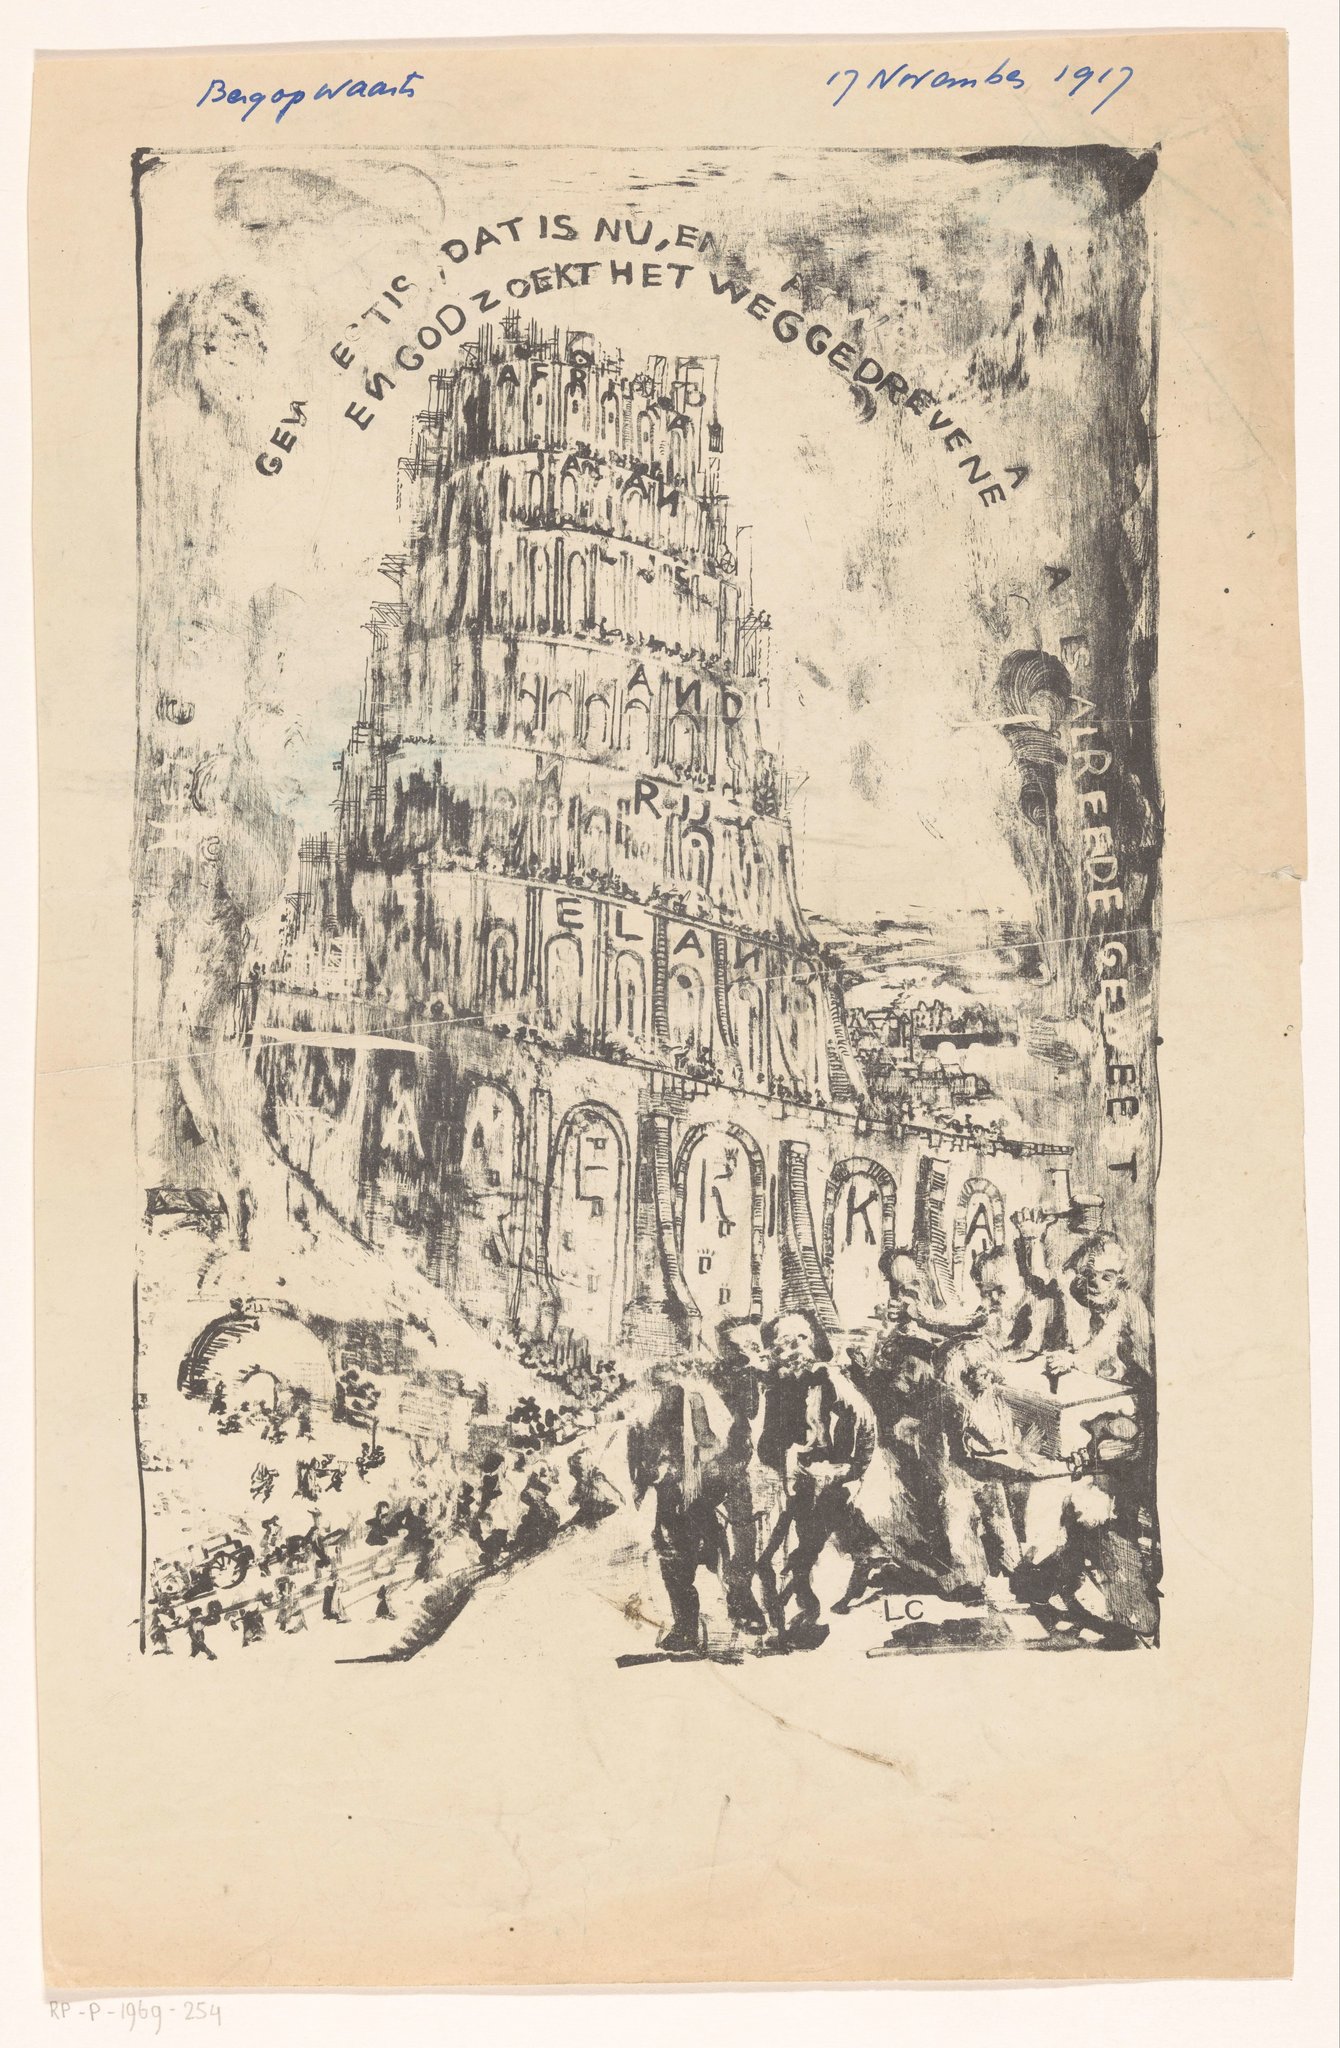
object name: print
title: Toren met landennamen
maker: carel adolph lion cachet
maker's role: draughtsman, print maker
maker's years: 1864-1945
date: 1917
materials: paper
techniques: lithograph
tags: the building of the tower of babel; nimrod may be present, supervising or assisting the construction, italy, russia, france, japan, england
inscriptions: collector's mark: Lugt 2228, date and inscription: ‘Bergopwaarts 17 November 1917’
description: Een toren in de steigers met op elke verdieping de naam van een gebied. Van onder naar boven: Amerika, Engeland, Frankrijk, Rusland, Italië, Japan en Afrika. Boven de toren de tekst: 'En God zoekt het weggedrevene'.